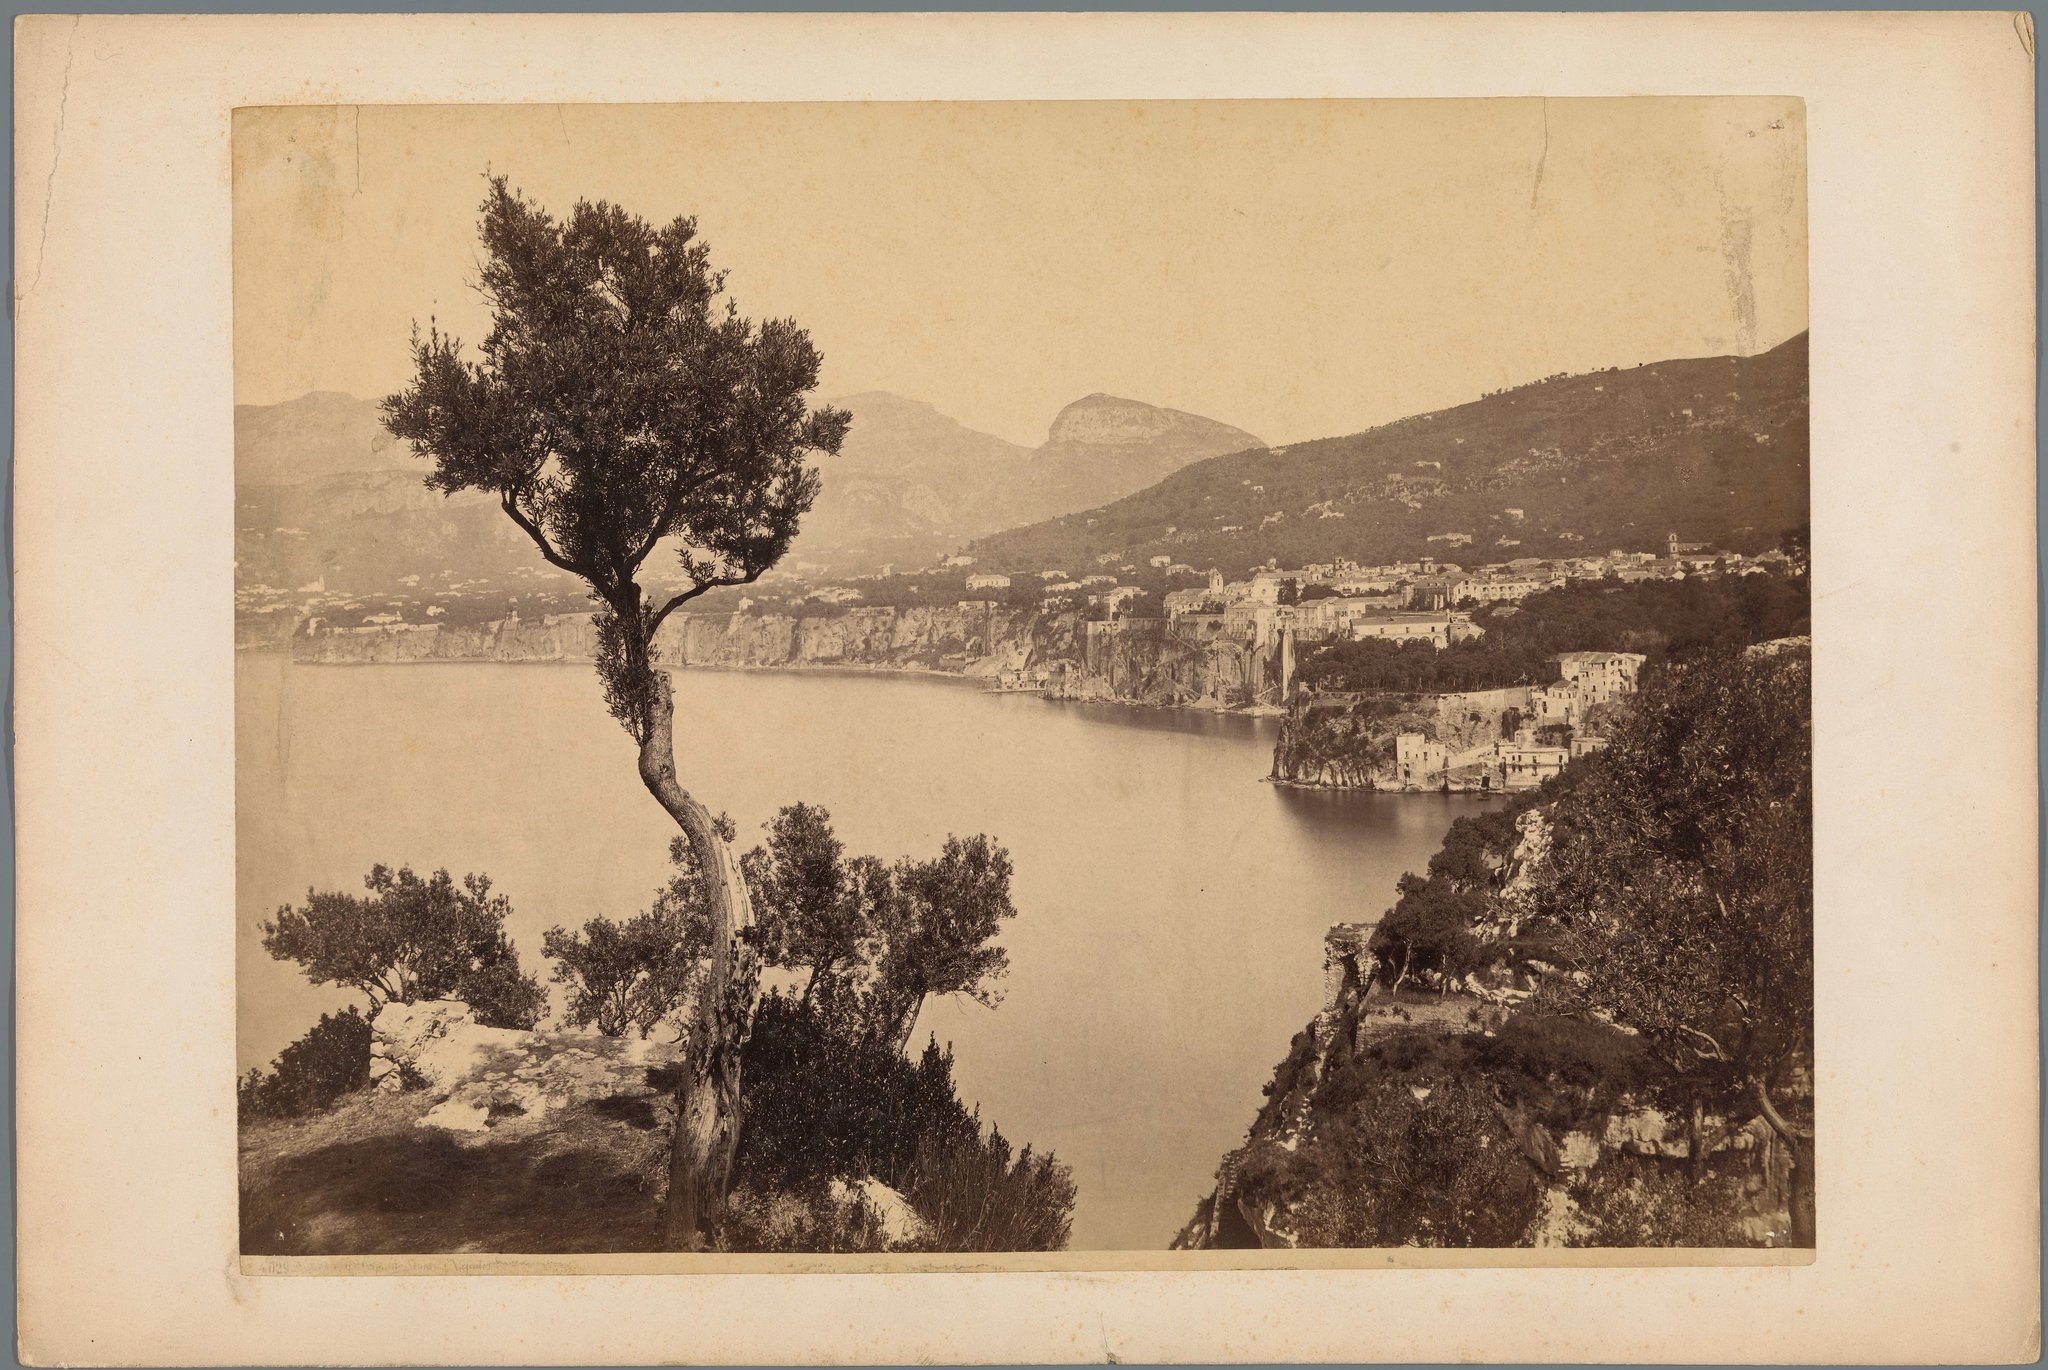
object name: photograph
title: Gezicht over een baai en een dorp op de rotsen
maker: Anonymous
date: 1875-1900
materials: cardboard, photographic support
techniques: albumen print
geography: southern europe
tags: gulf, bay - hh - ideal landscapes, trees: olive-tree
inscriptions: number: ‘4029’, collector's mark: Lugt 3937